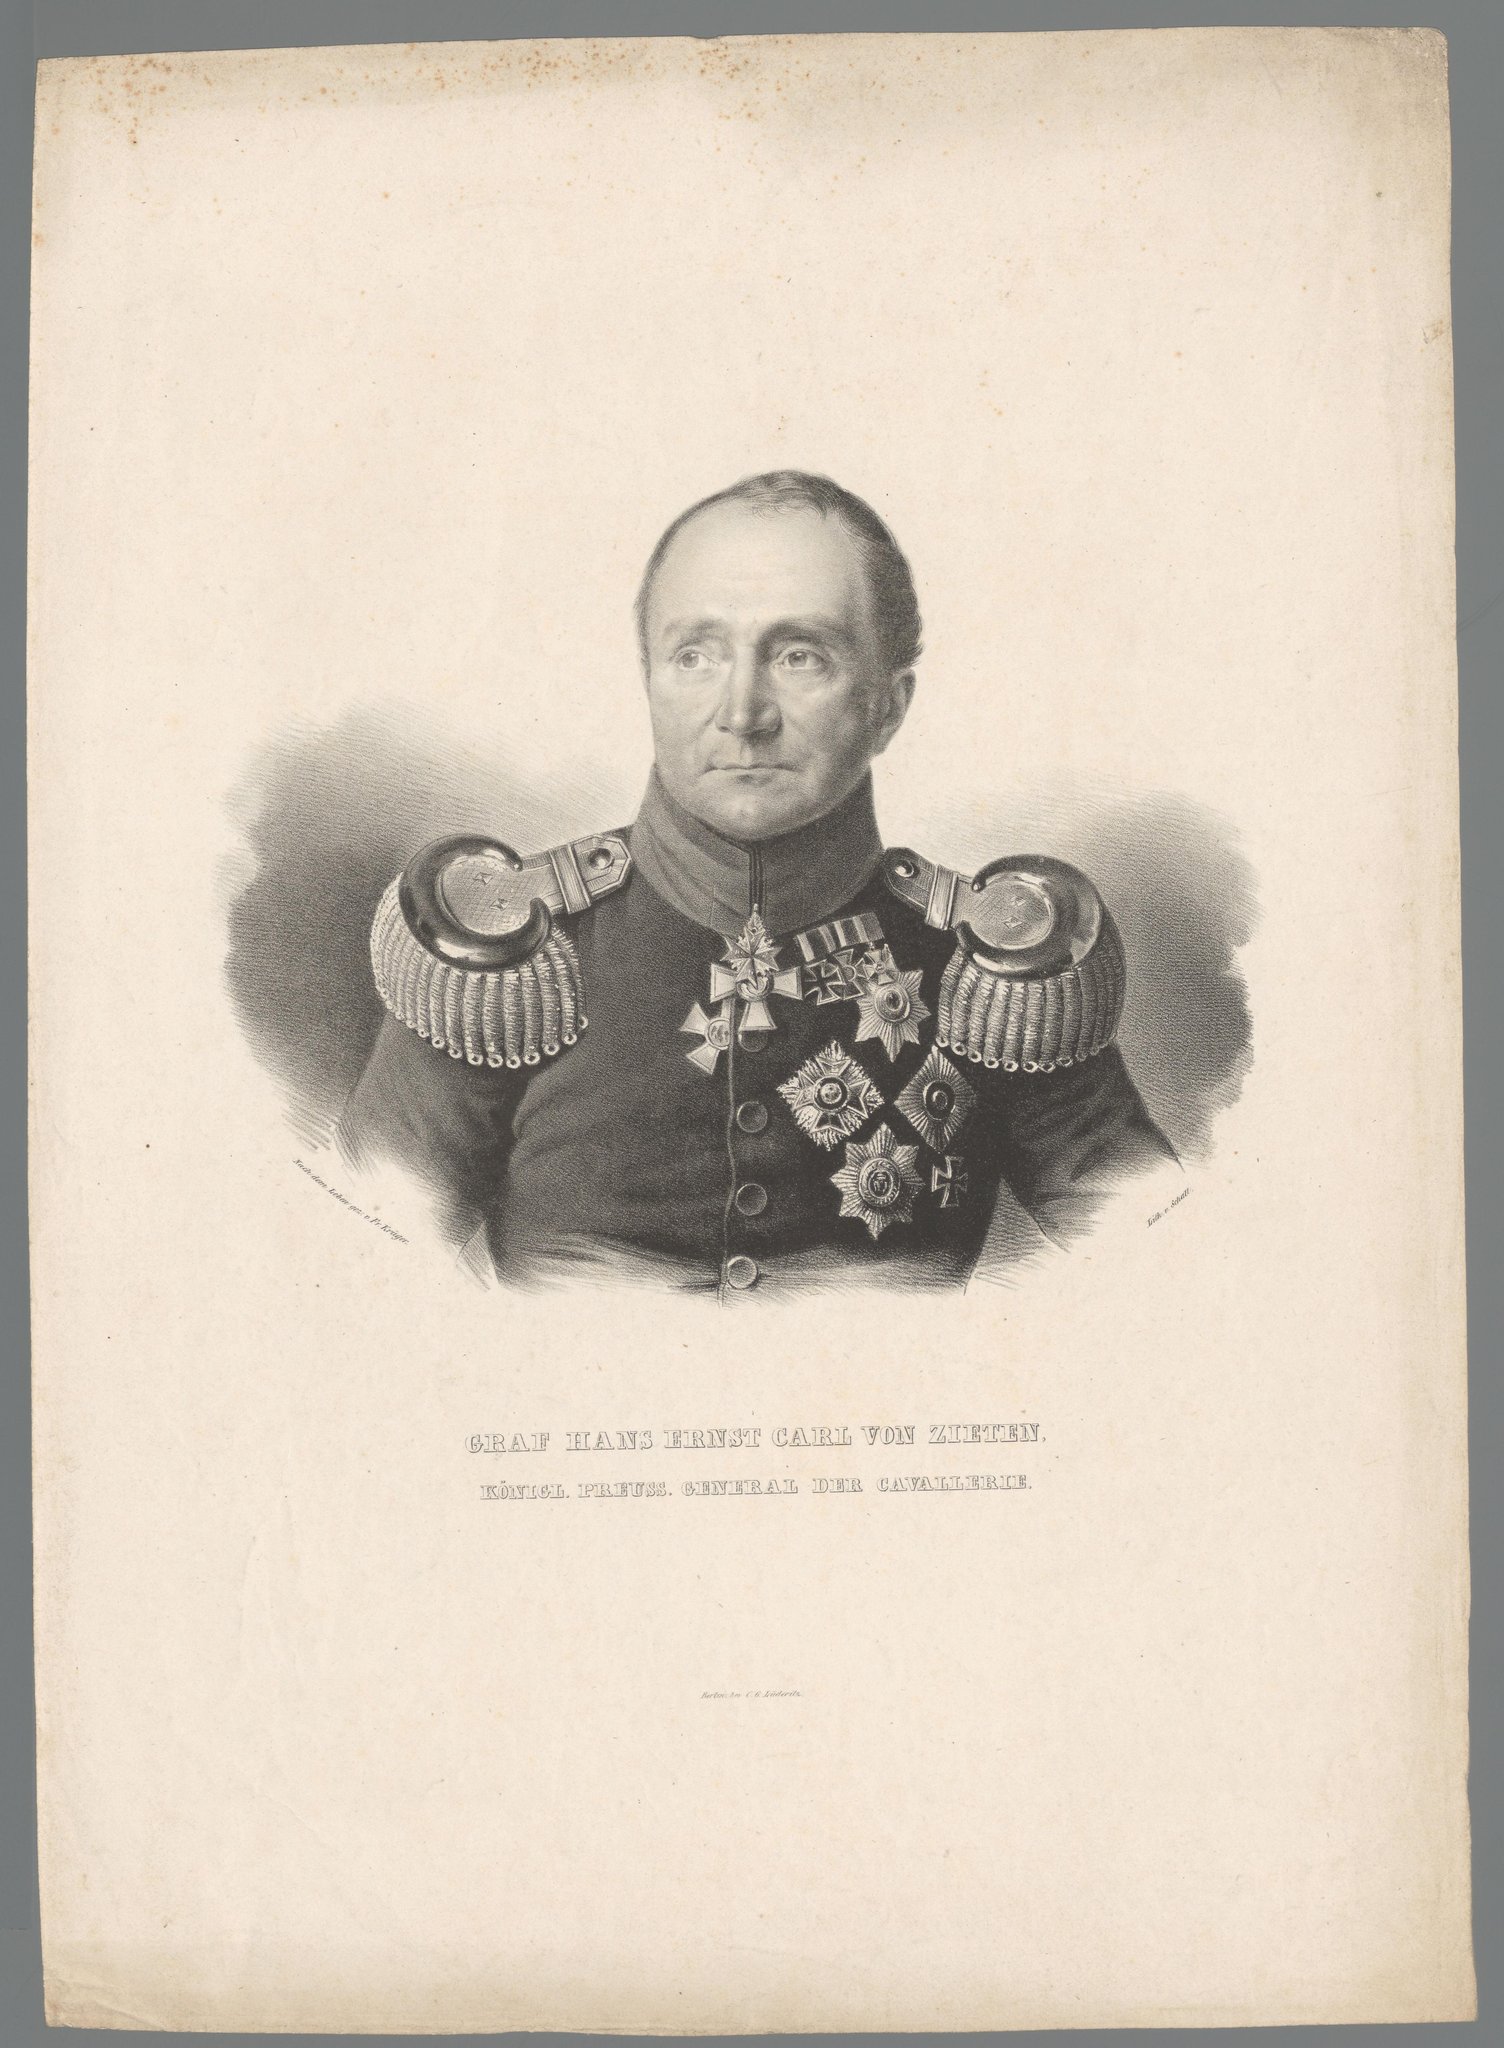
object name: print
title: Portret van Hans Ernst Karl von Zieten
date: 1830-1860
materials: paper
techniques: lithograph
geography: berlin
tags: commander-in-chief, general, marshal, historical persons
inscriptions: collector's mark: Lugt 2228